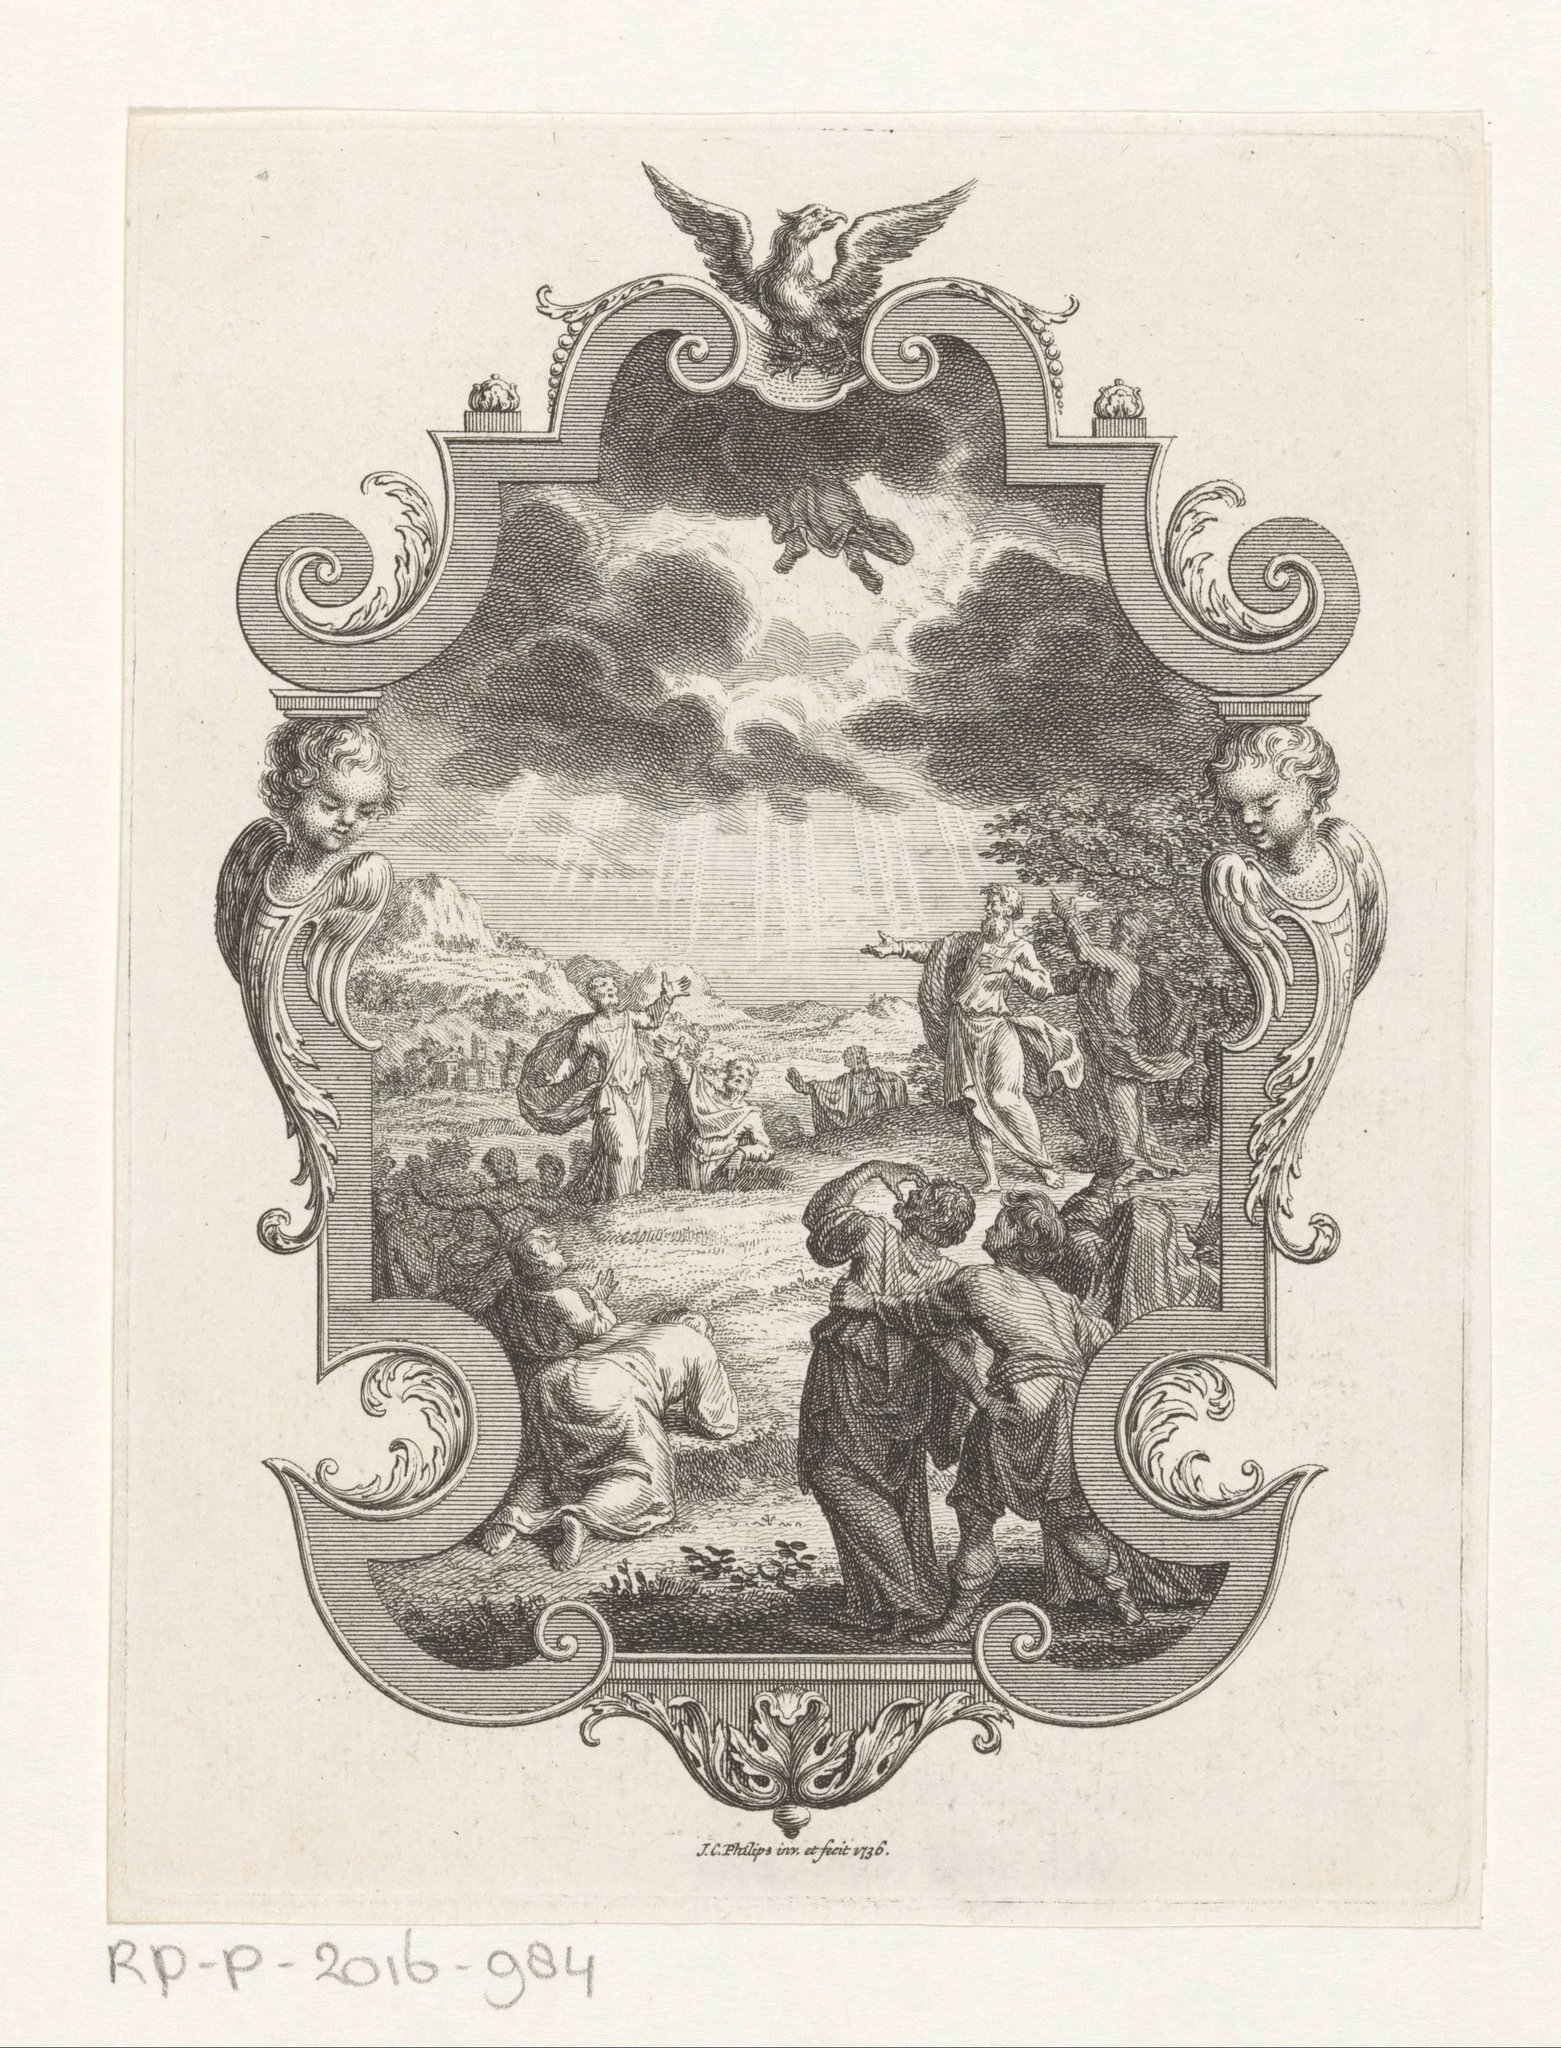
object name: print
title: Cartouche met de hemelvaart van Christus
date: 1736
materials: paper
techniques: engraving, etching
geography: amsterdam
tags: the ascension (christ surrounded by radiant light or in a mandorla), predatory birds: eagle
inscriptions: collector's mark: Lugt 2228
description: Prent uit: Kramer, Adriaan de. Alle de werken. Amsterdam: Sligtenhorst, Hendrik, 1736. Prent afkomstig uit een plakalbum met titelprenten, ornamenten etc. op blauw papier in 1983 uit elkaar gehaald. Volgens een notitie op verso zat de prent op p. 81 van dit album.